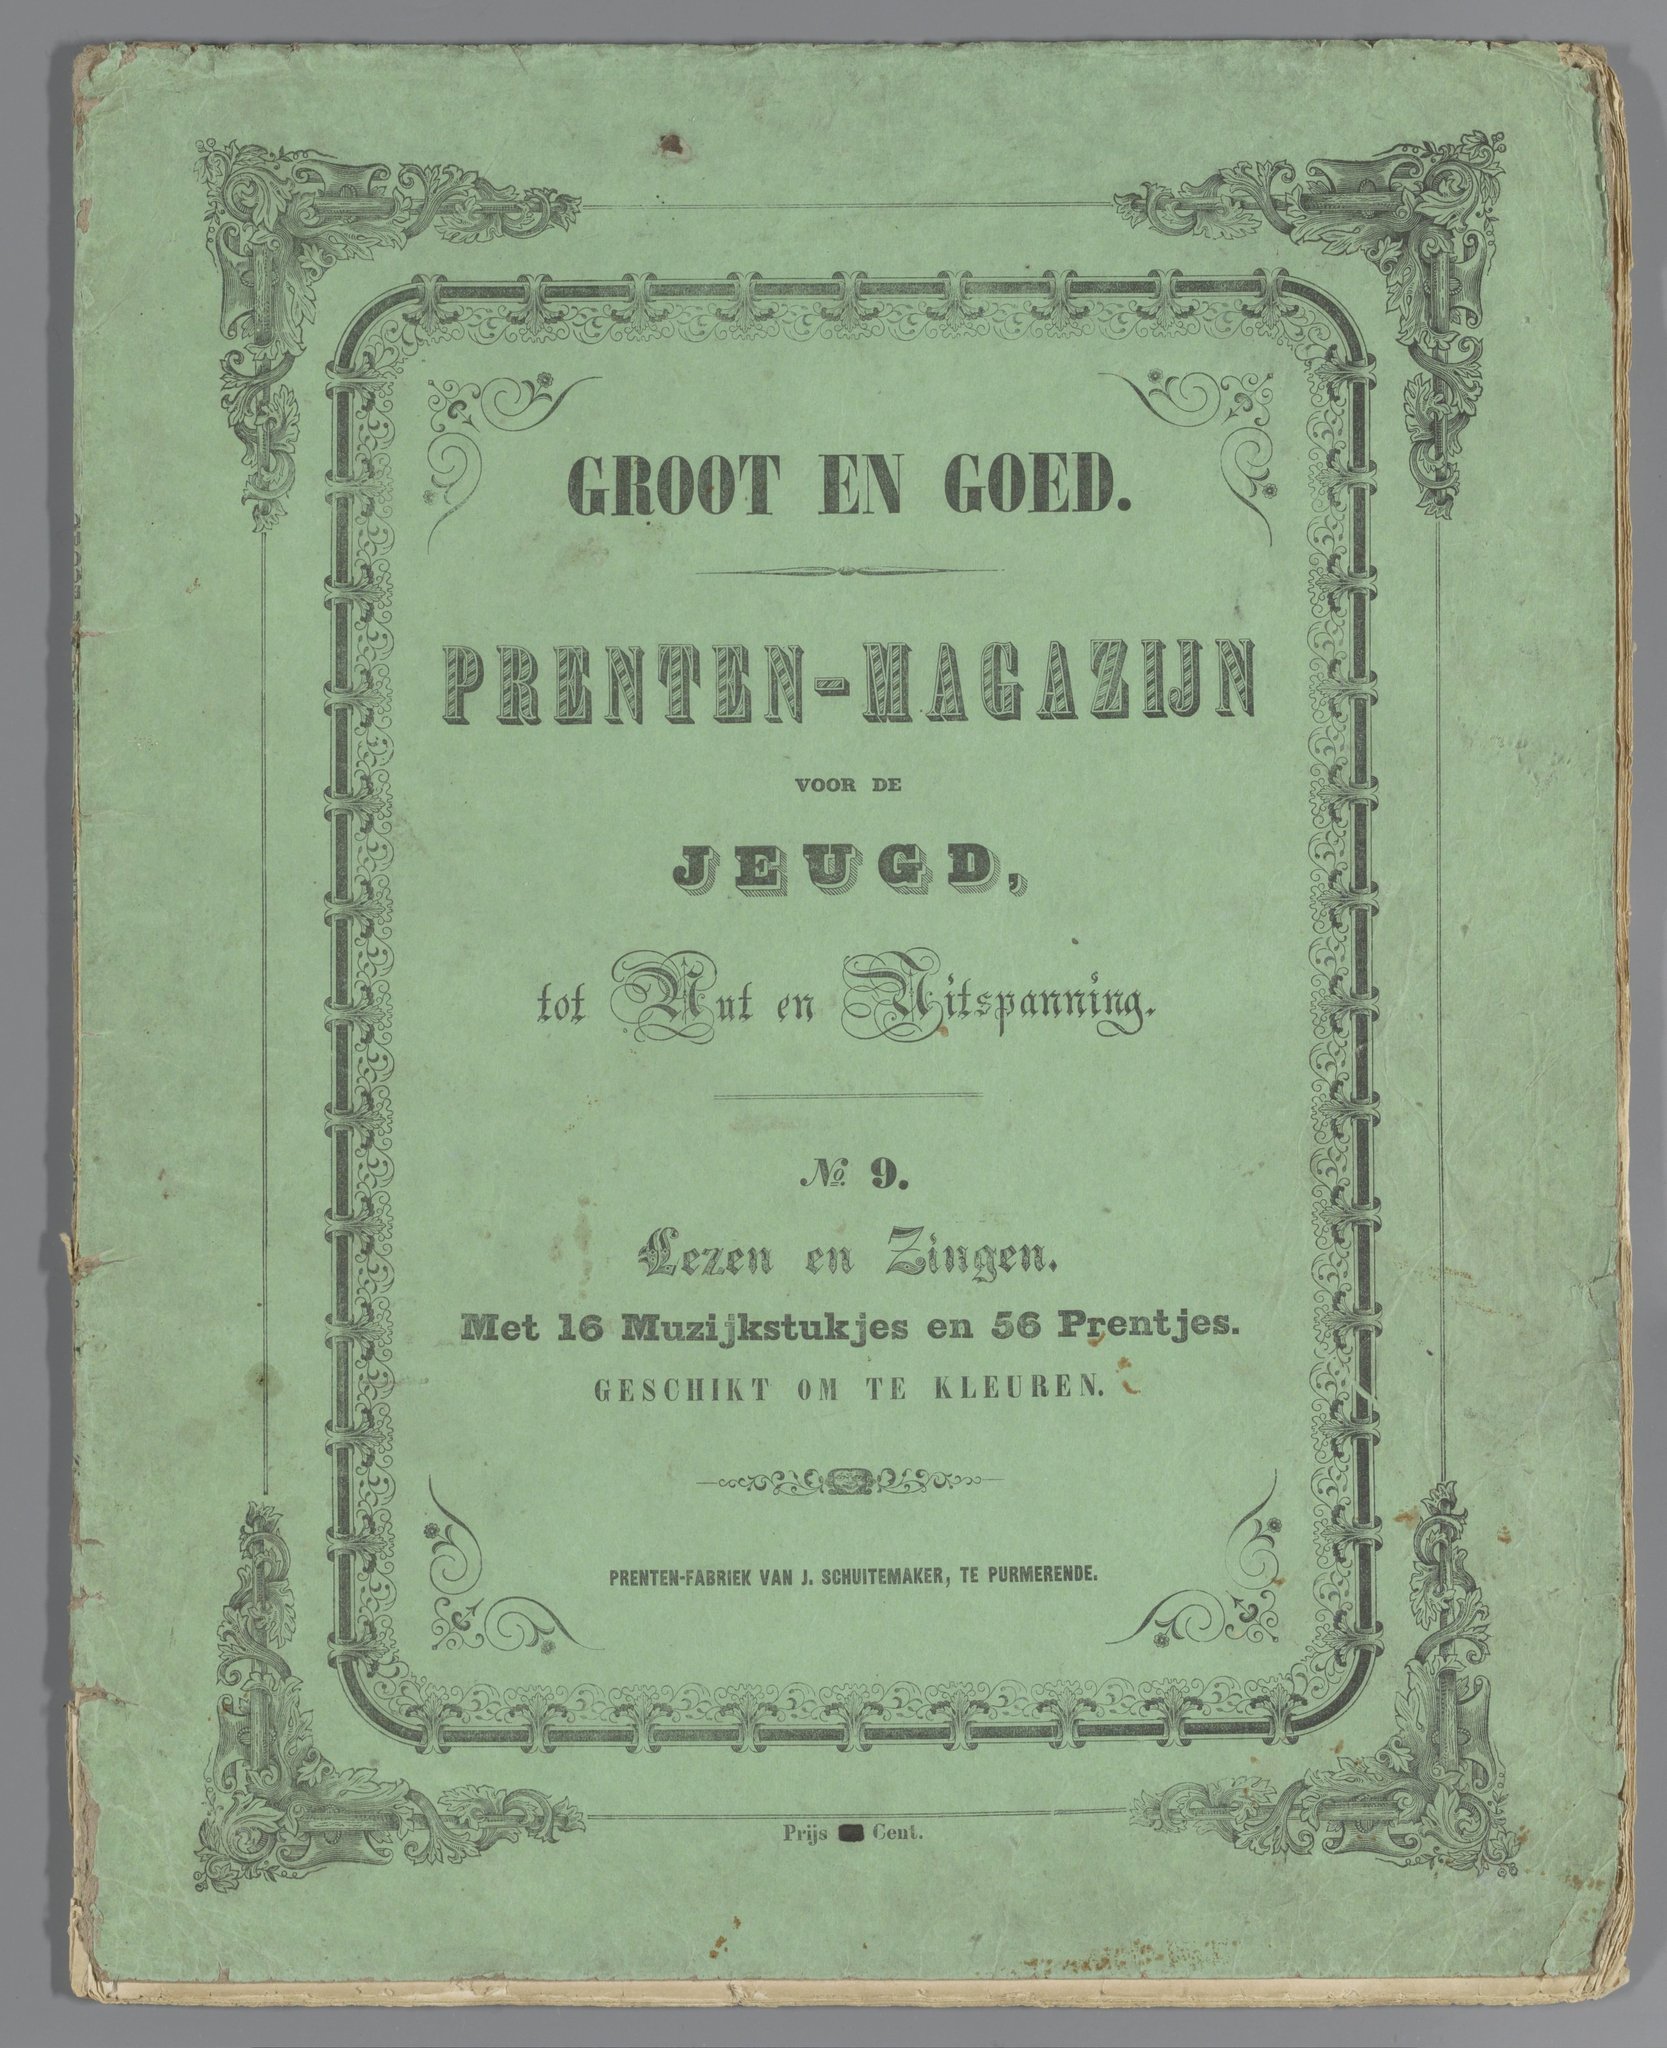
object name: picture book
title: Prenten-magazijn / voor de / jeugd, / tot nut en uitspanning / No. 9. / Lezen en Zingen. / Met 16 muzijkstukjes en 56 prentjes. / Geschikt of te kleuren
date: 1853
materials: cardboard, paper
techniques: letterpress printing, engraving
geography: purmerend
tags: printed edition of musical score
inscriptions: date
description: Het prentenboek bevat op de eerste pagina een 'Eere-prijs'. Eere-Prijs ter beloning en aanmoediging geschonken aan A den Hertog Leerling in de 2e Klasse 1e Afdeeling op de openbare school van Oudshoorn en den Gnephoek (Oudshoorn den 26 mei 1854, De Commissie van Plaatselijk School-Toevoorzigt).